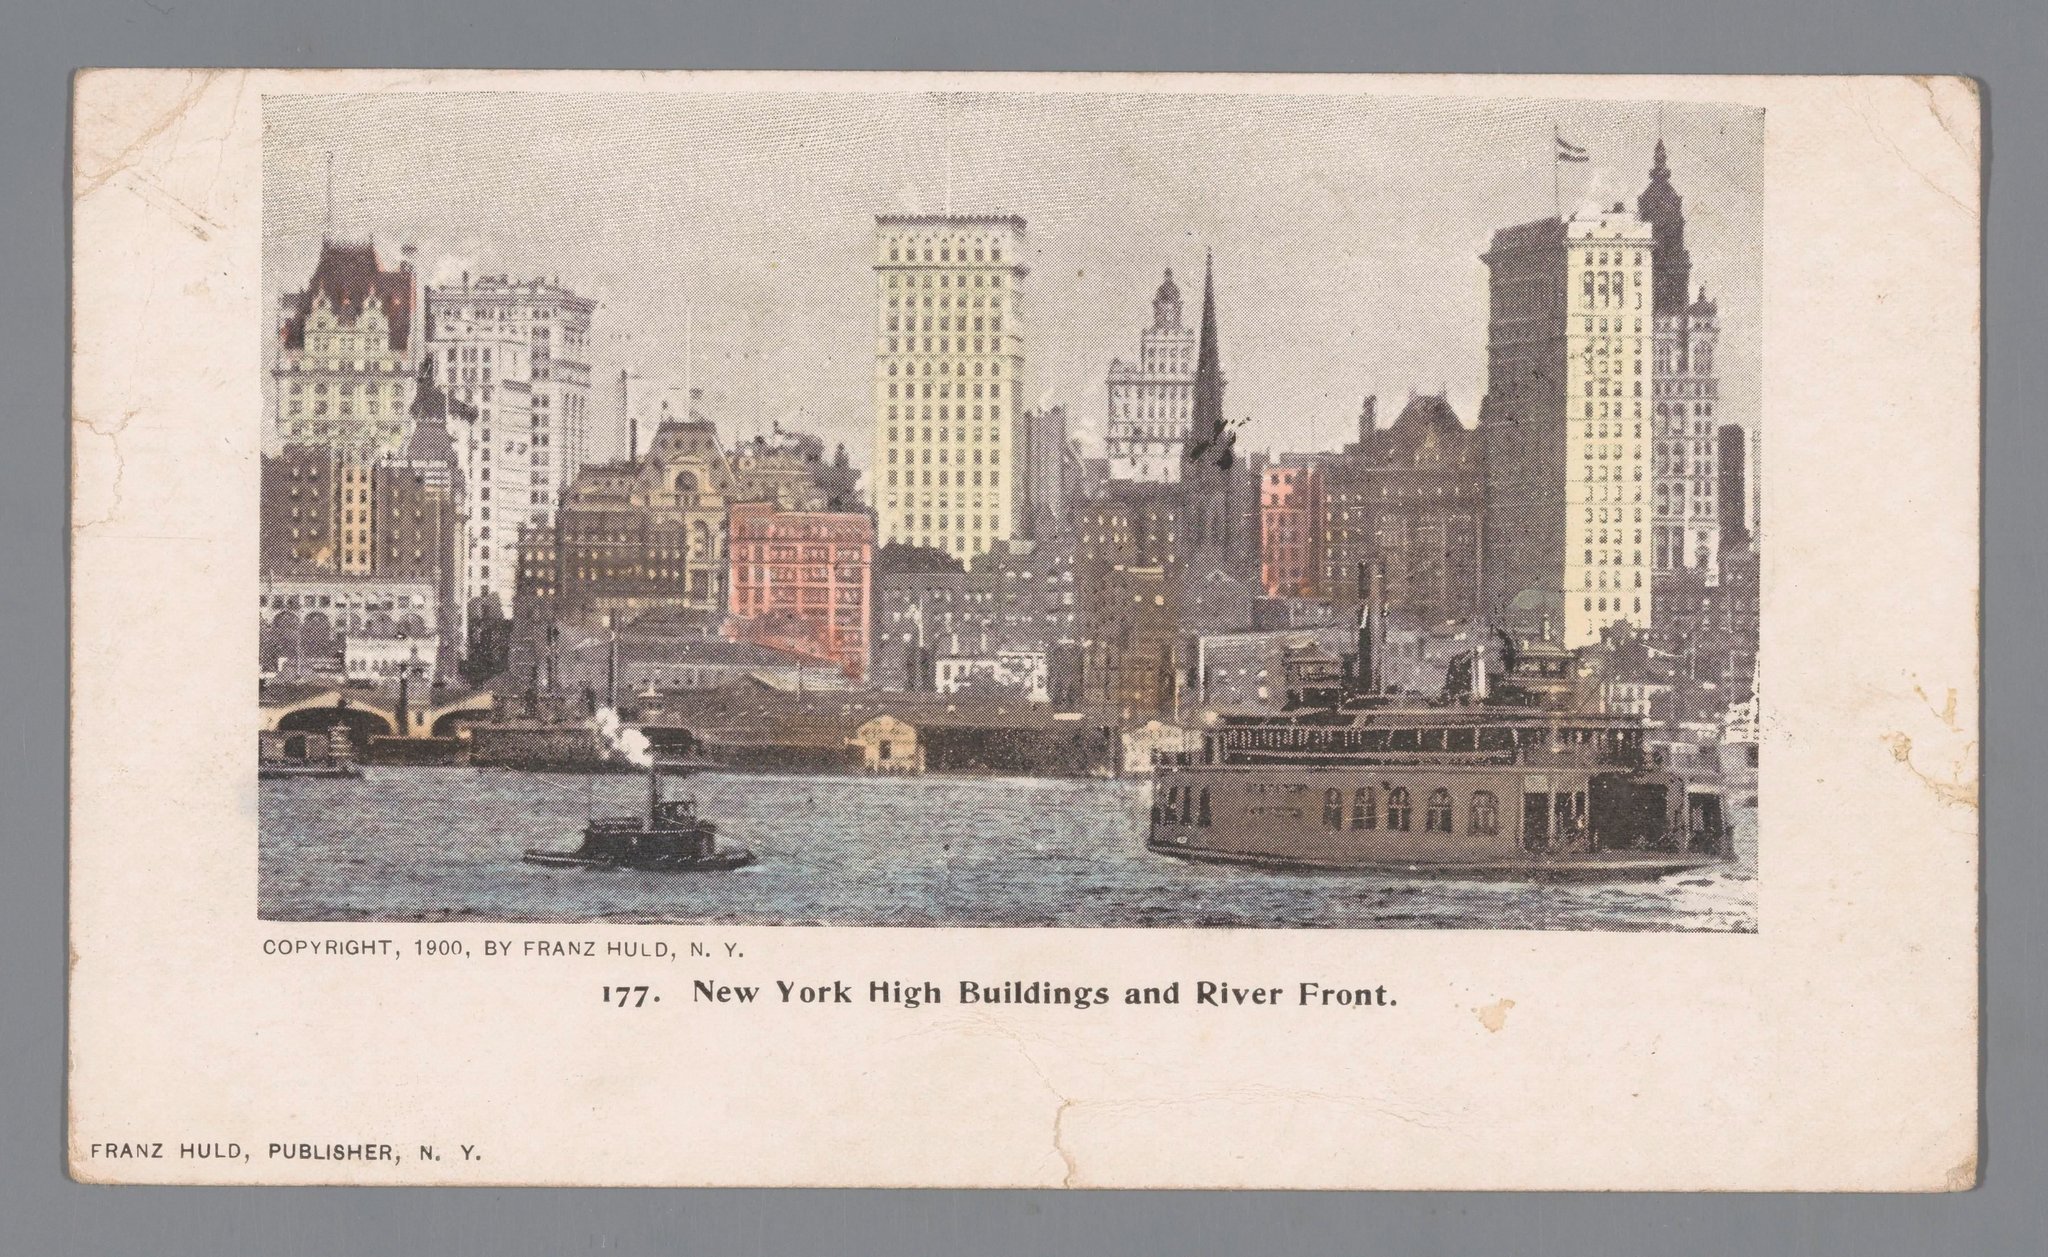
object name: ansichtkaart, prentbriefkaart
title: New York High Buildings and River Front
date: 1898-1900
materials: paper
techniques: autotype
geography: new york city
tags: city-view, and landscape with man-made constructions, river, new york (city)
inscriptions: number: ‘177.’, inscription: ‘Dr. Heer. O. Bergman Wir[...]ummerdijk Leeuwarden Holland’